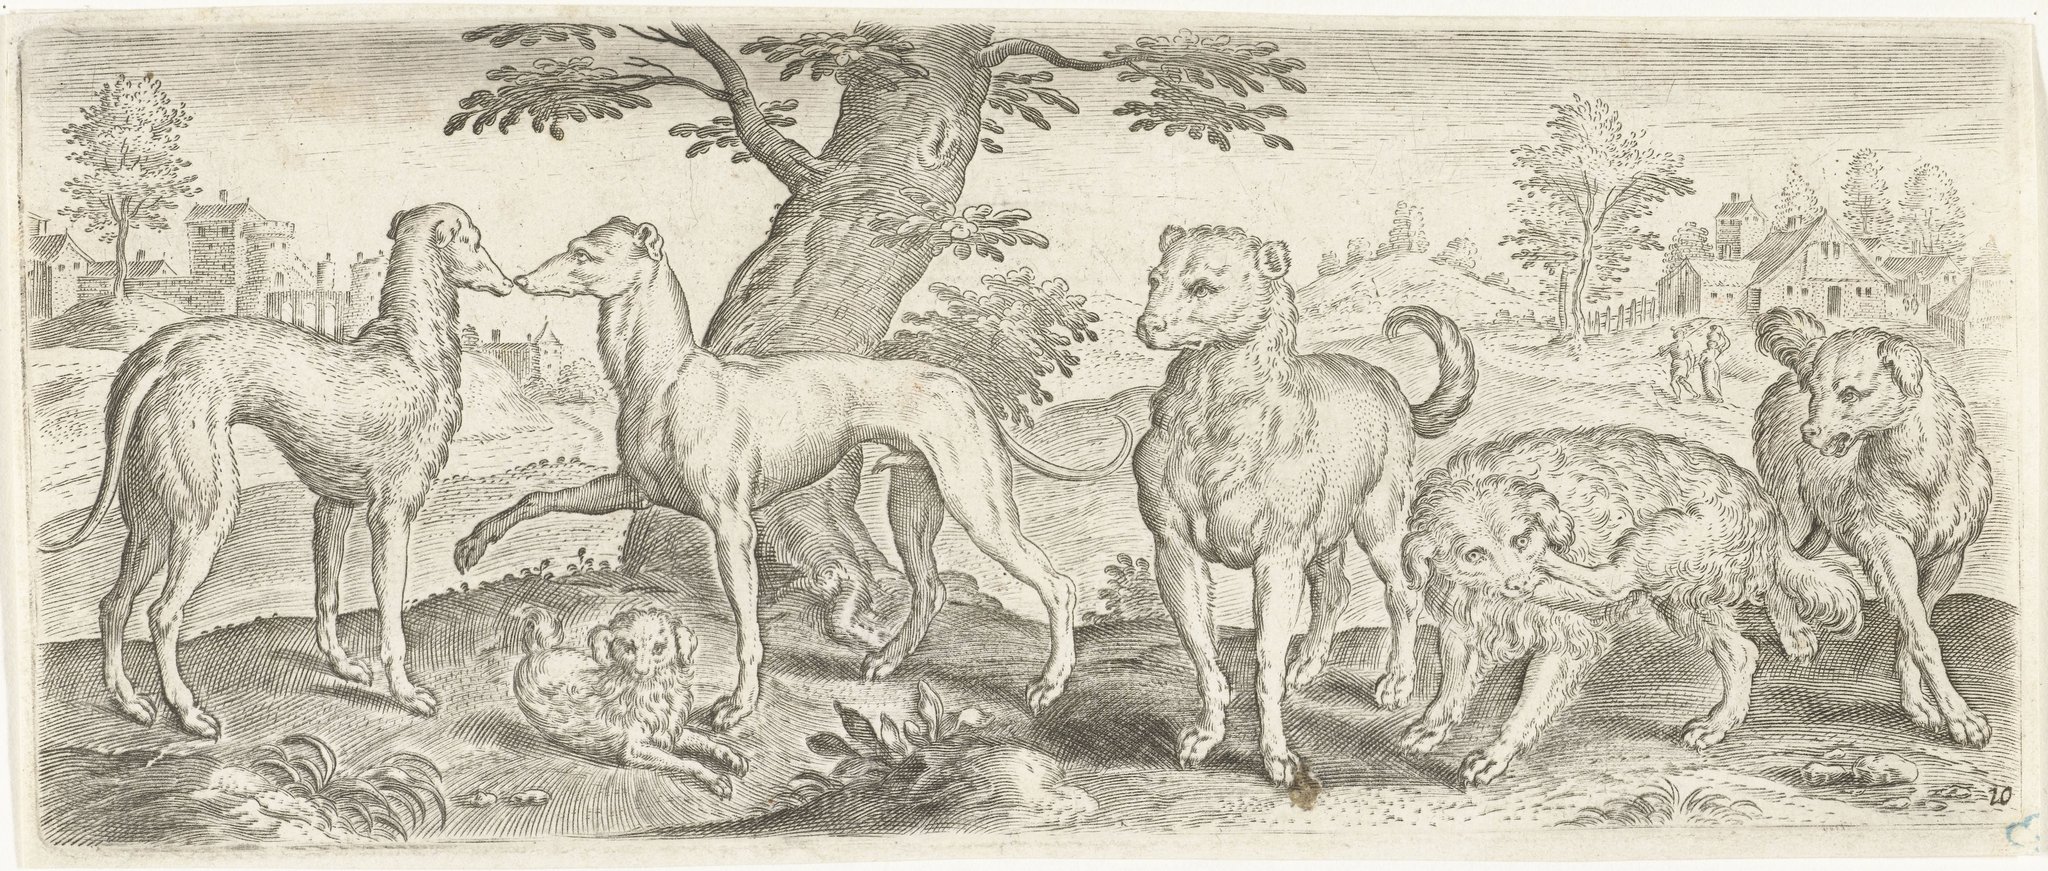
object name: print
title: Dieren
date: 1583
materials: paper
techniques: engraving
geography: antwerp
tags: landscape with tower or castle, dog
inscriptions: collector's mark: Lugt 2228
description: Een verzameling van 6 soorten honden (langharige windhonden, kortharige windhonden, schoothondjes, etc.). De honden staan of zitten en eentje krabt aan zijn oor. Op de achtergrond een landschap met huizen en twee wandelaars.